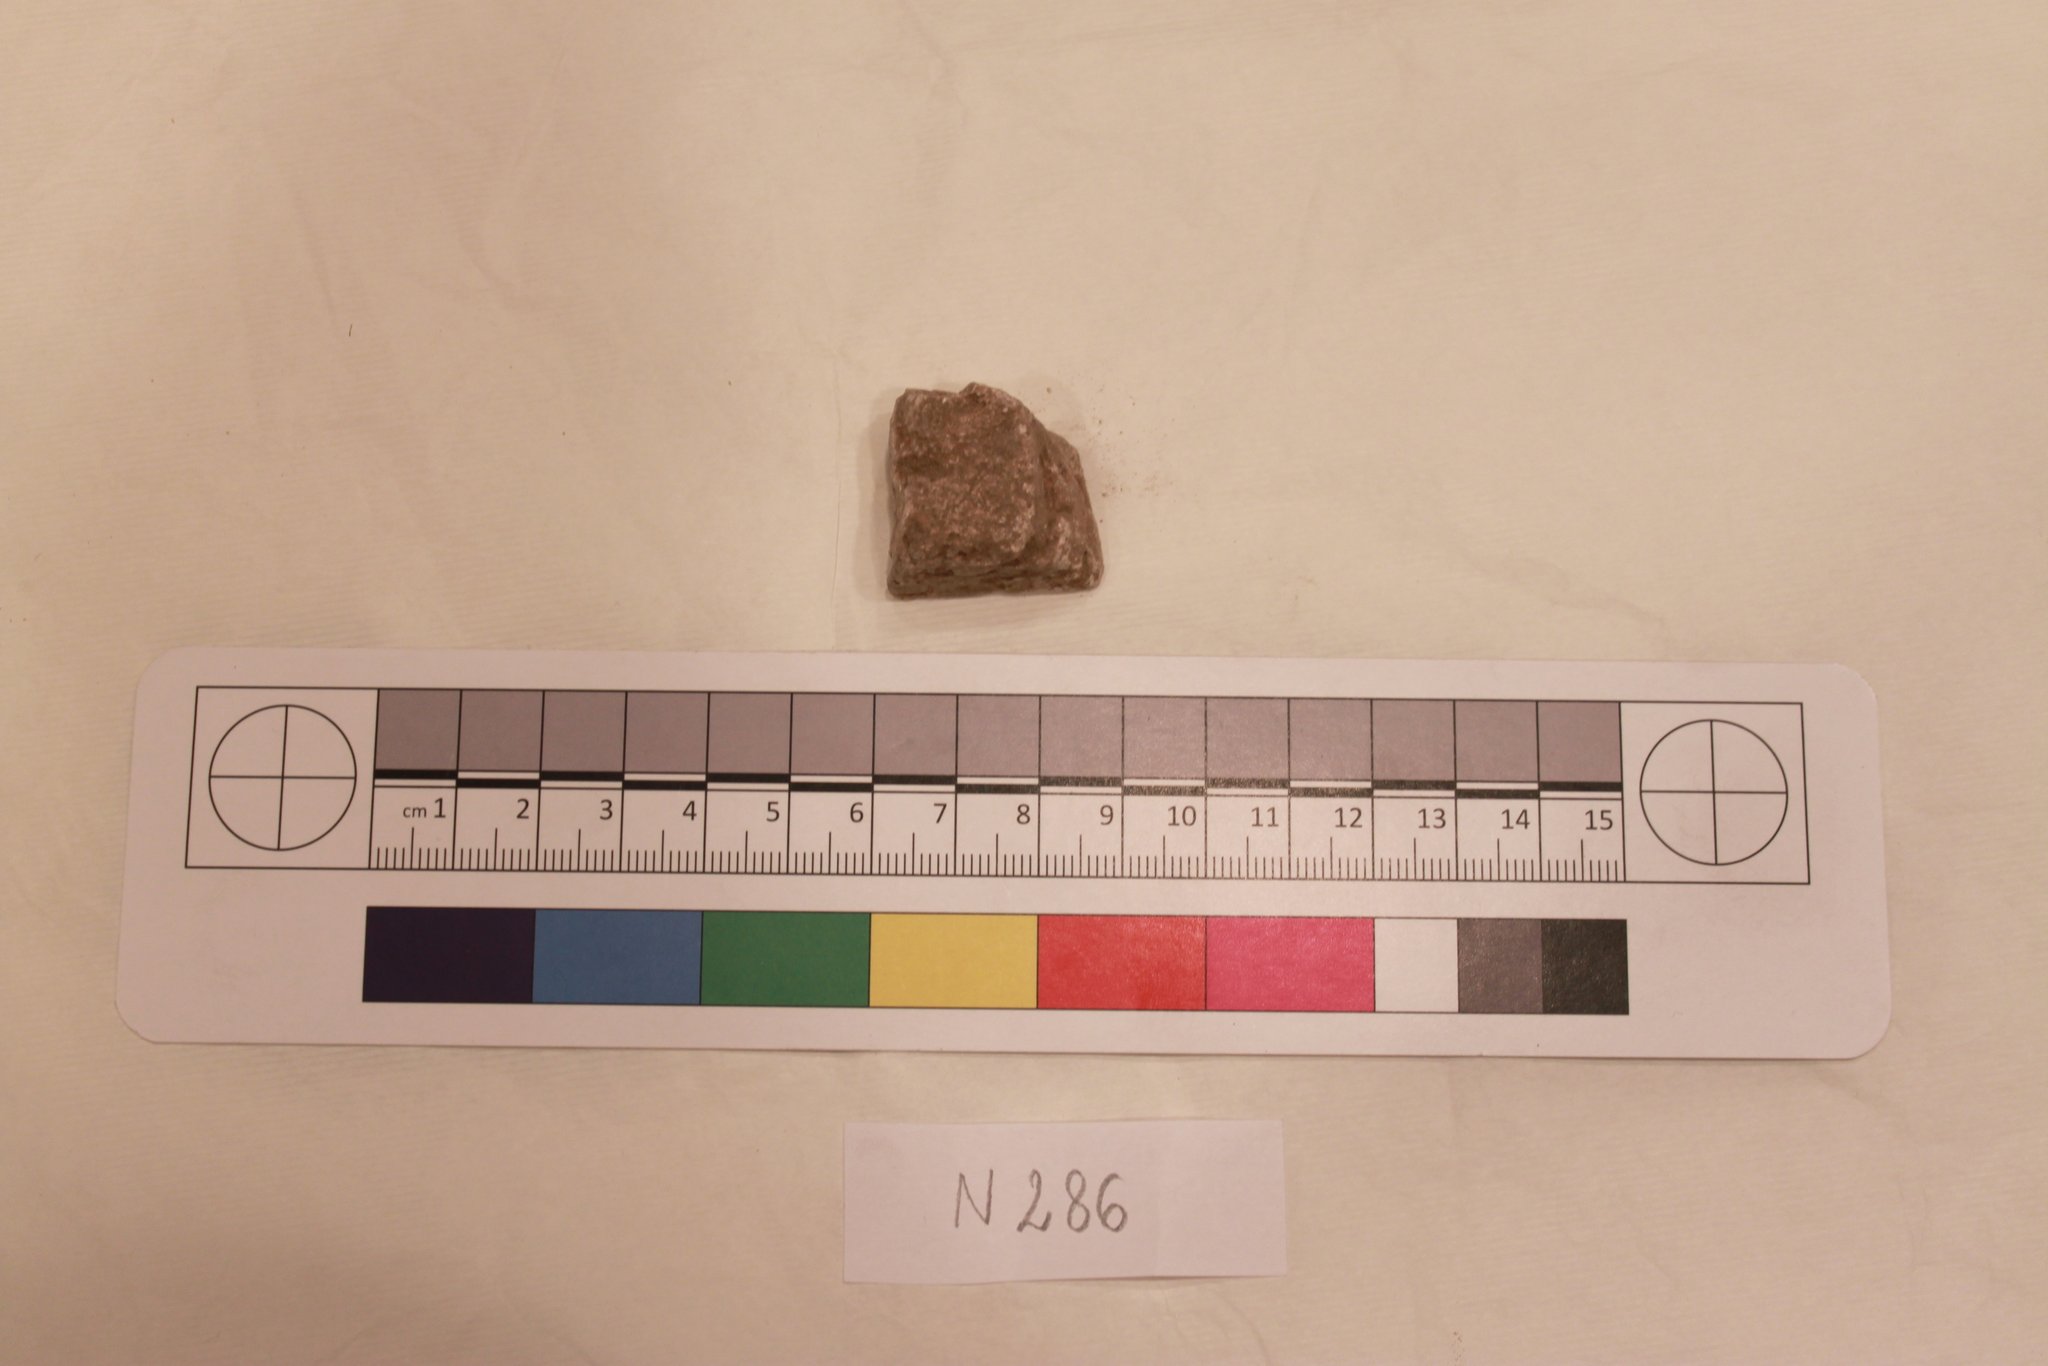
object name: fragment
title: Stucco Fragment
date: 701-1200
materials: plaster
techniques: carving, painting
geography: iran